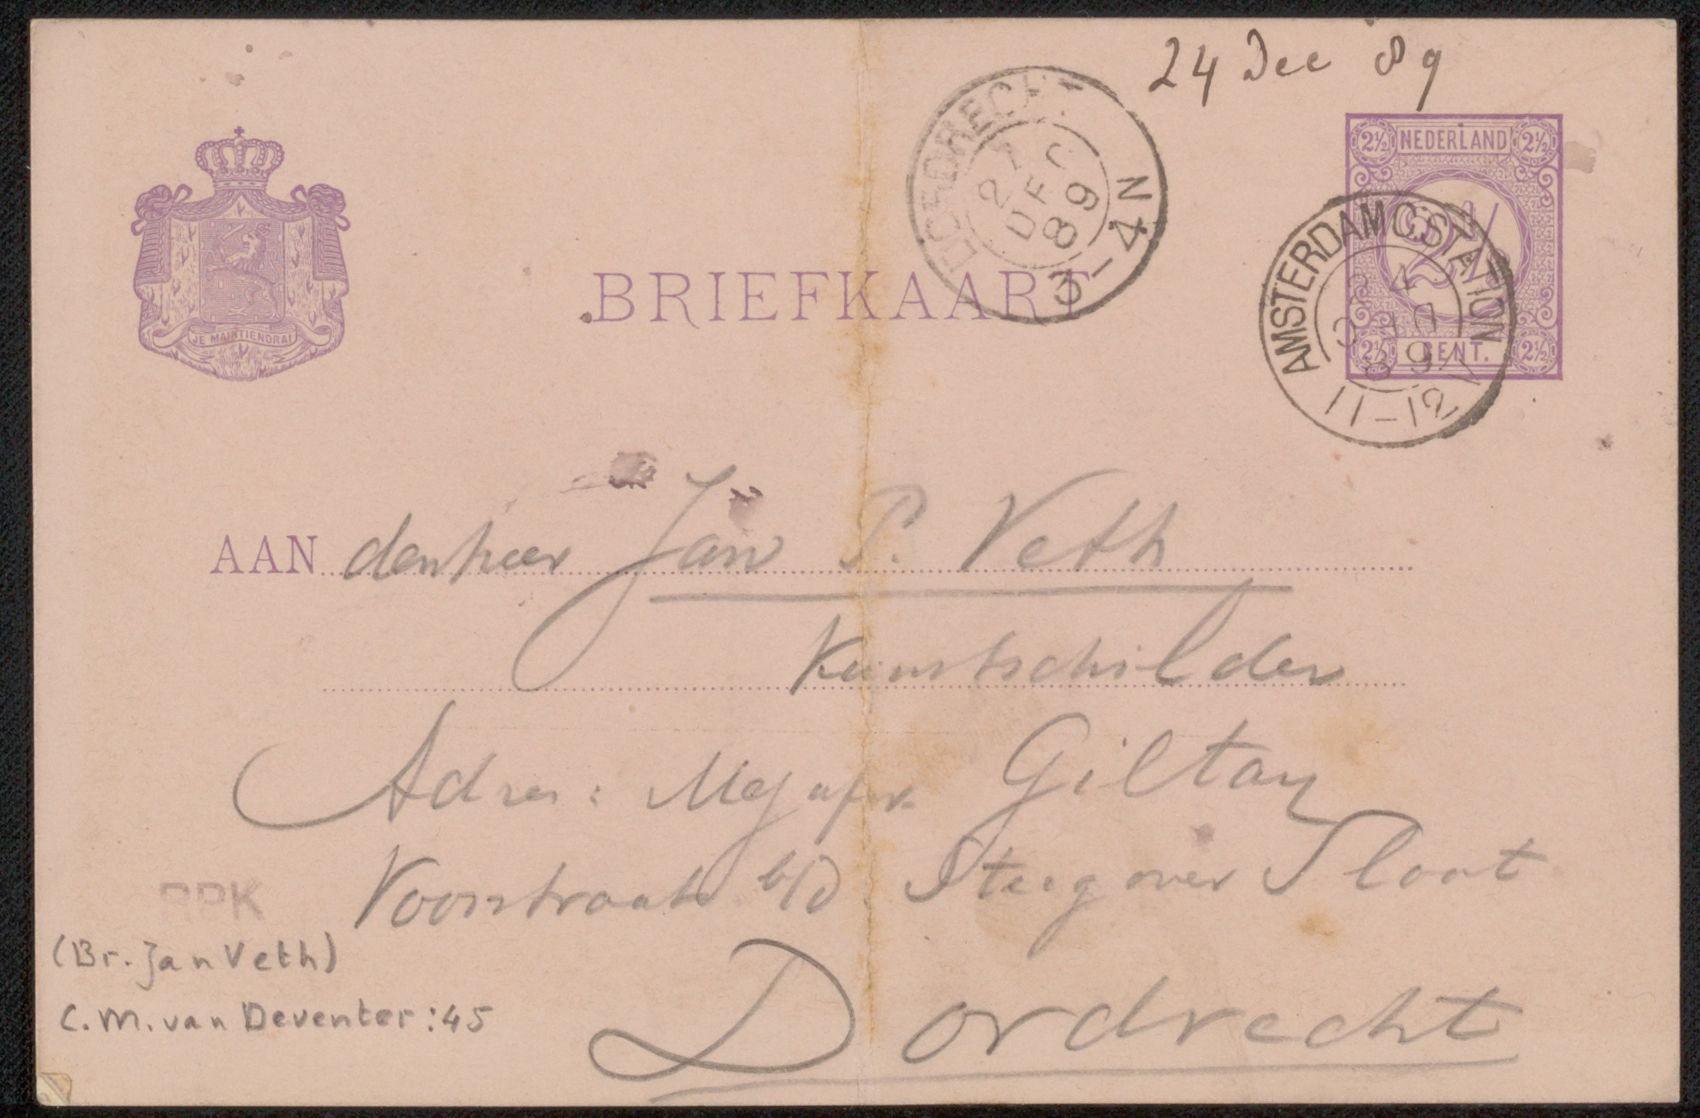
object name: postcard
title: Briefkaart aan Jan Veth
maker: chap van deventer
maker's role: kunstcriticus, scheikundige, schrijver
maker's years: 1860-1931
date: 1889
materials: cardboard, pencil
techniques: writing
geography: amsterdam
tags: painter, print maker, draughtsman, designer, jan veth, family life, dordrecht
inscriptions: collector's mark: ‘RPK’